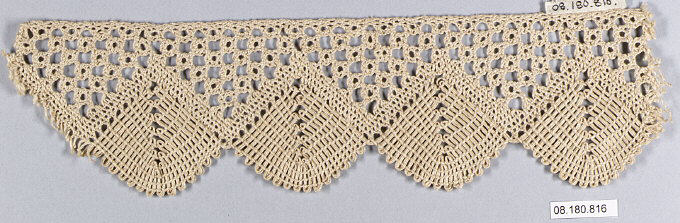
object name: fragment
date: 1801-1900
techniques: lace